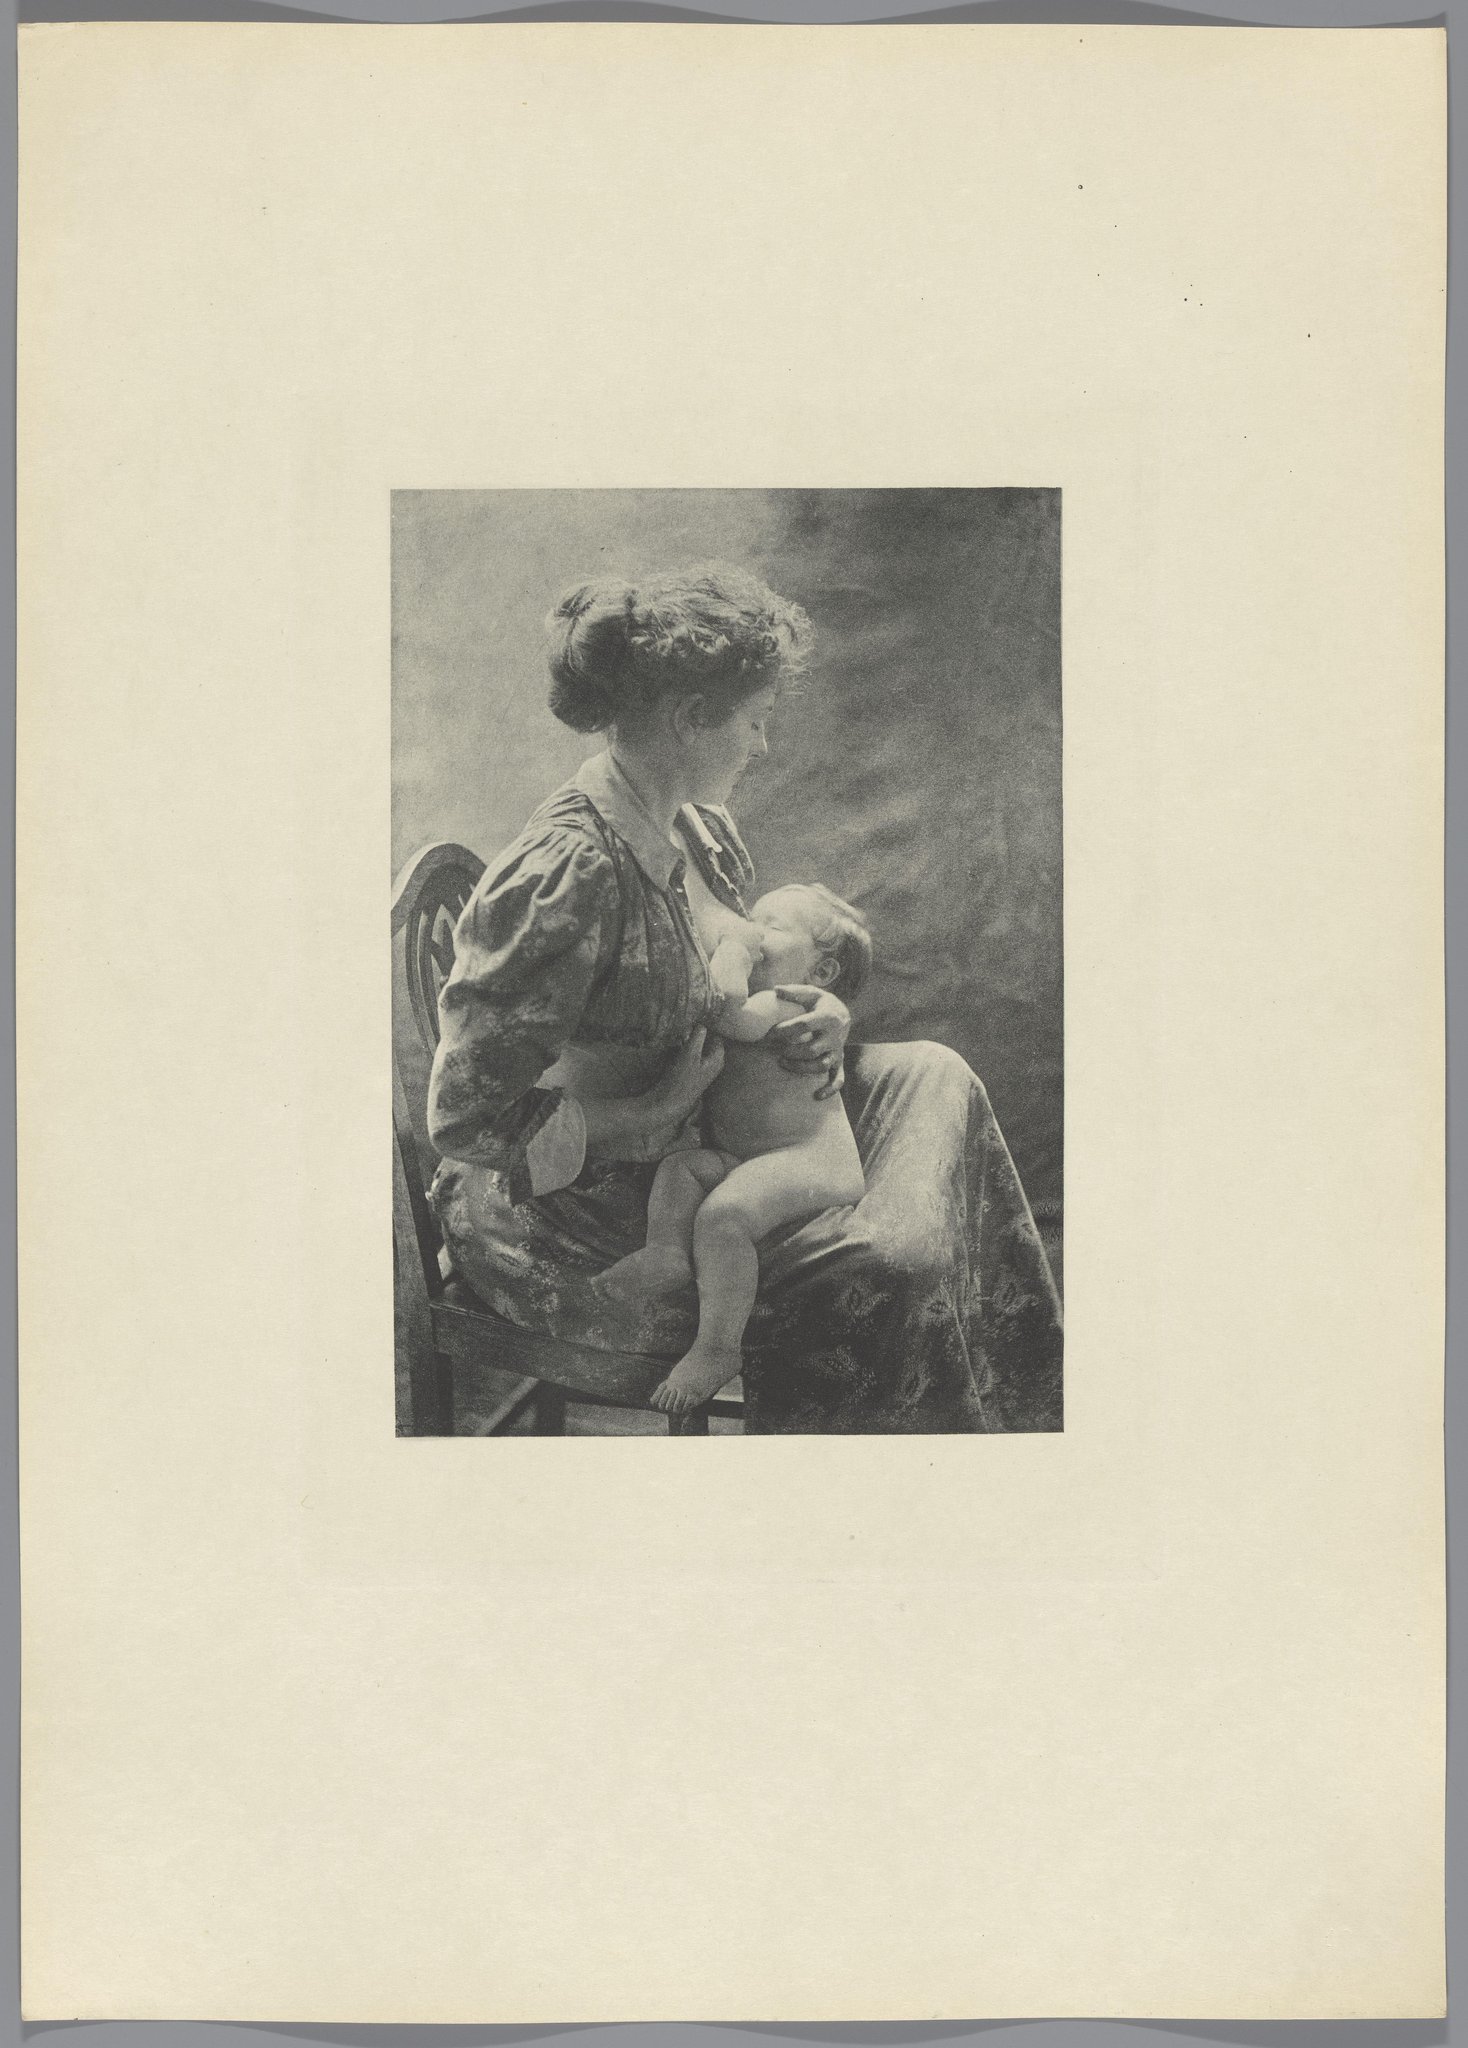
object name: photomechanical print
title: Portret van een onbekende vrouw met kind aan de borst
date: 1891-1896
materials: paper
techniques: photoaquatint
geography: paris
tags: breasts giving milk - aa - female human figure, historical persons not known by name - bb - woman, feeding a baby, mother and baby or young child